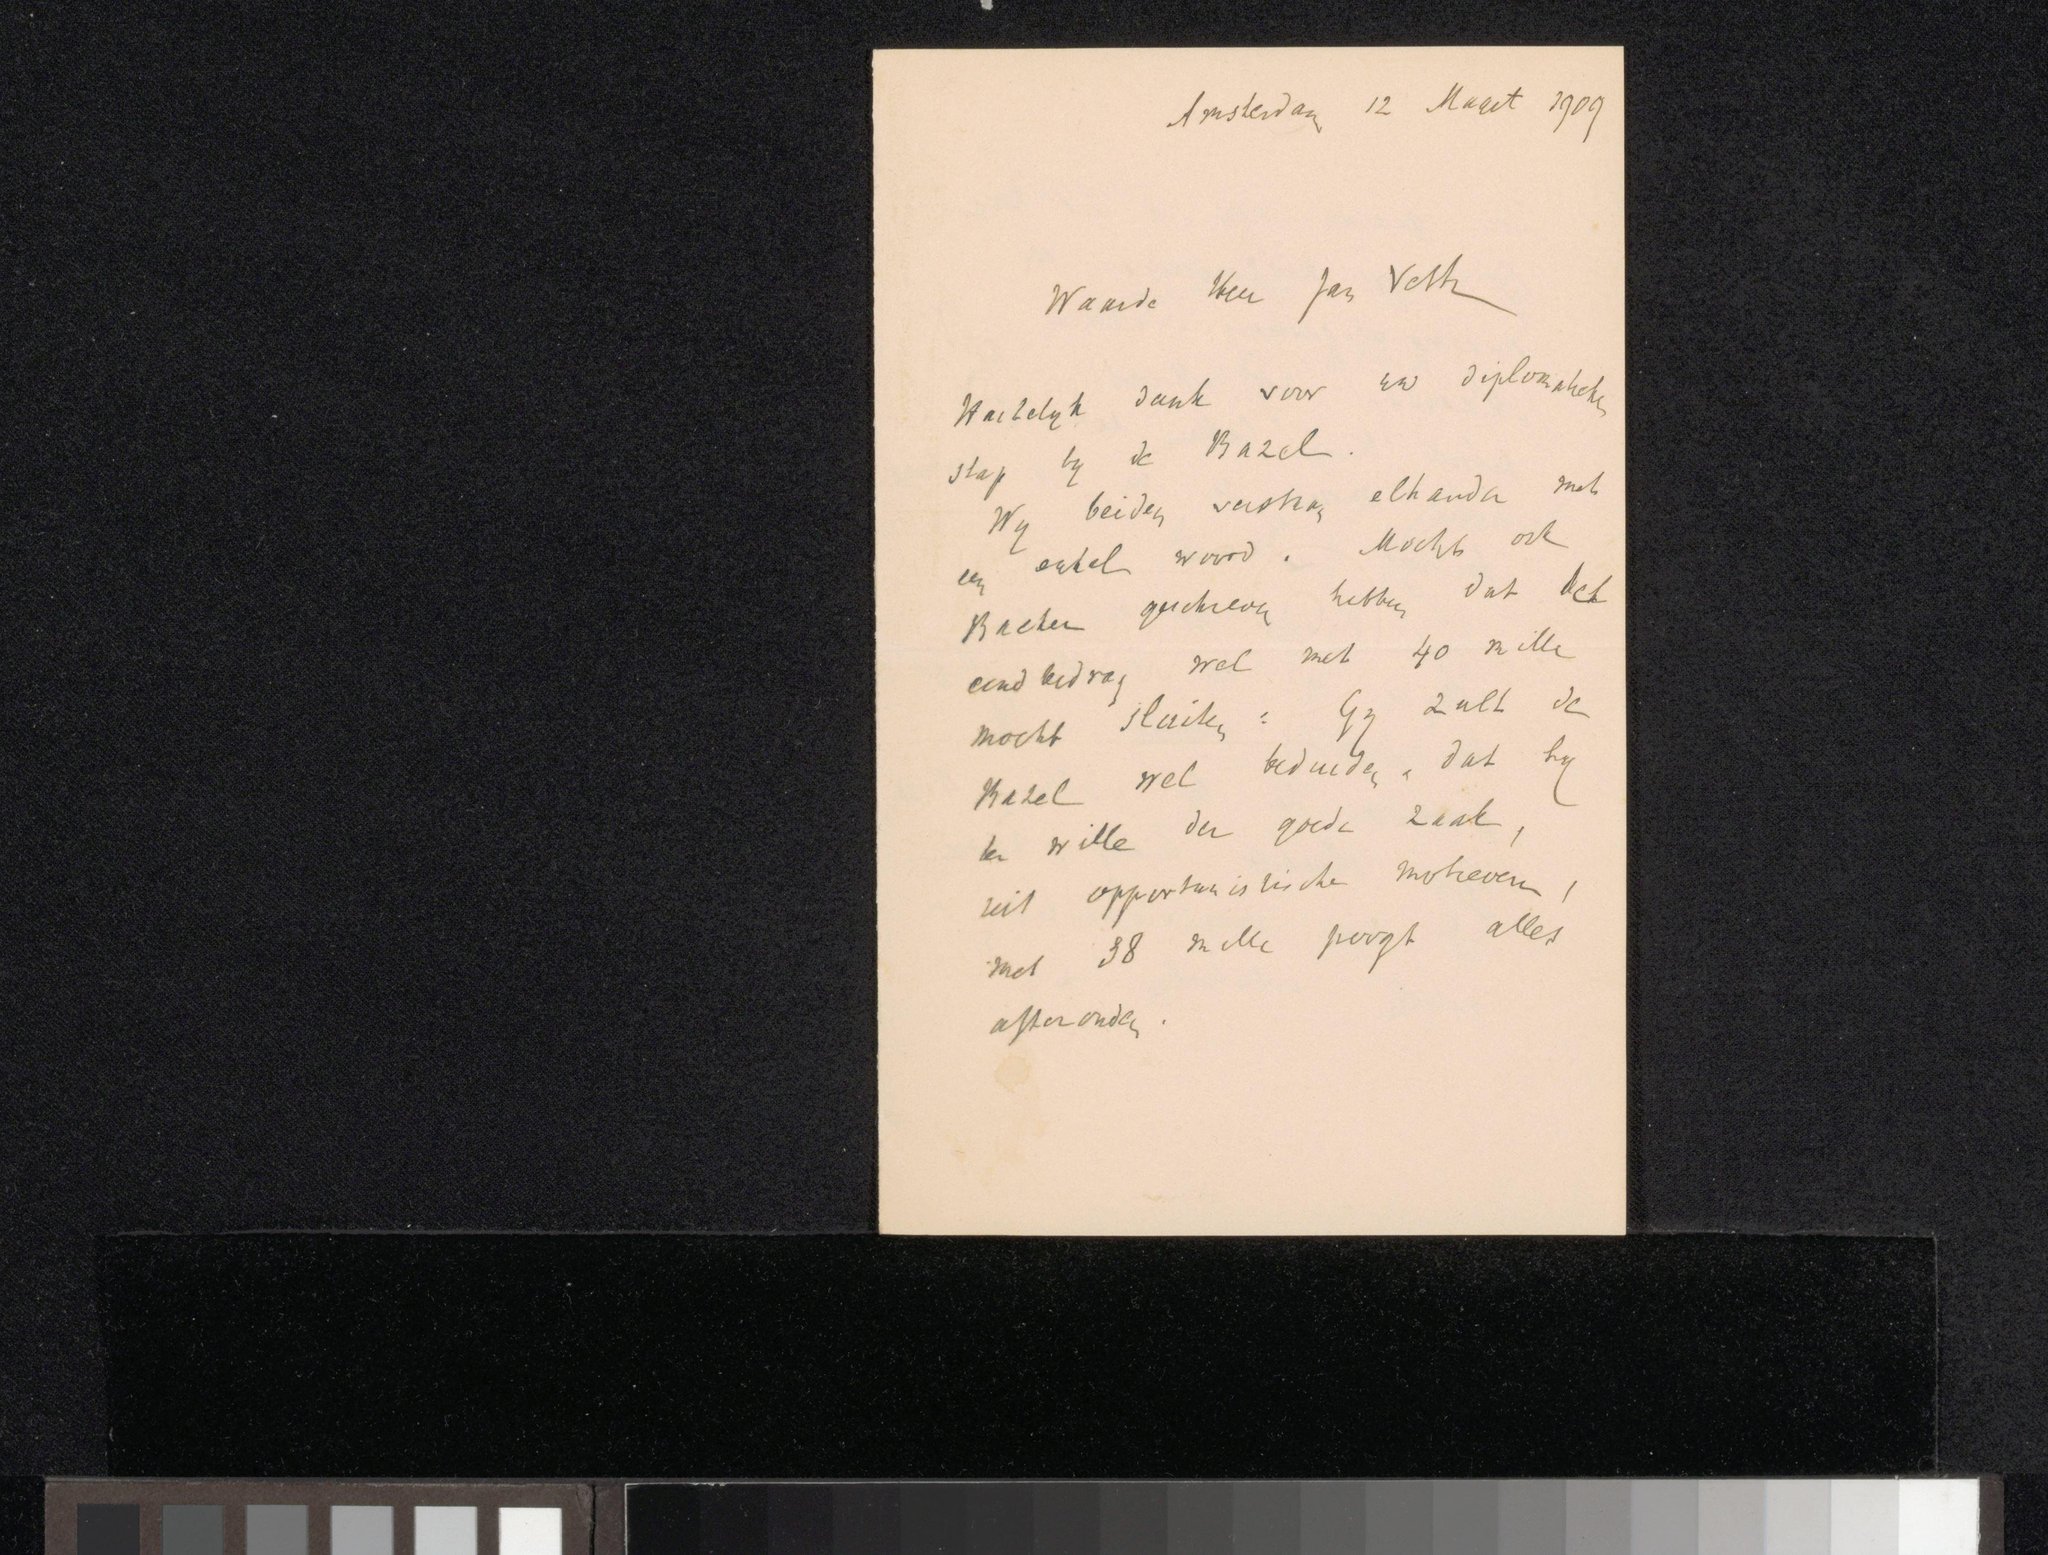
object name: letter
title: Brief aan Jan Veth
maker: hendrick peter godfried quack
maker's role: econoom, geschiedschrijver, hoogleraar, jurist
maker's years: 1834-1917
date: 1909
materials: ink, paper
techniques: pen, writing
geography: amsterdam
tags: painter, designer, jan veth, den helder, amsterdam, print maker, draughtsman, karel petrus cornelis de bazel, money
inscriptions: watermark, collector's mark: ‘RPK’